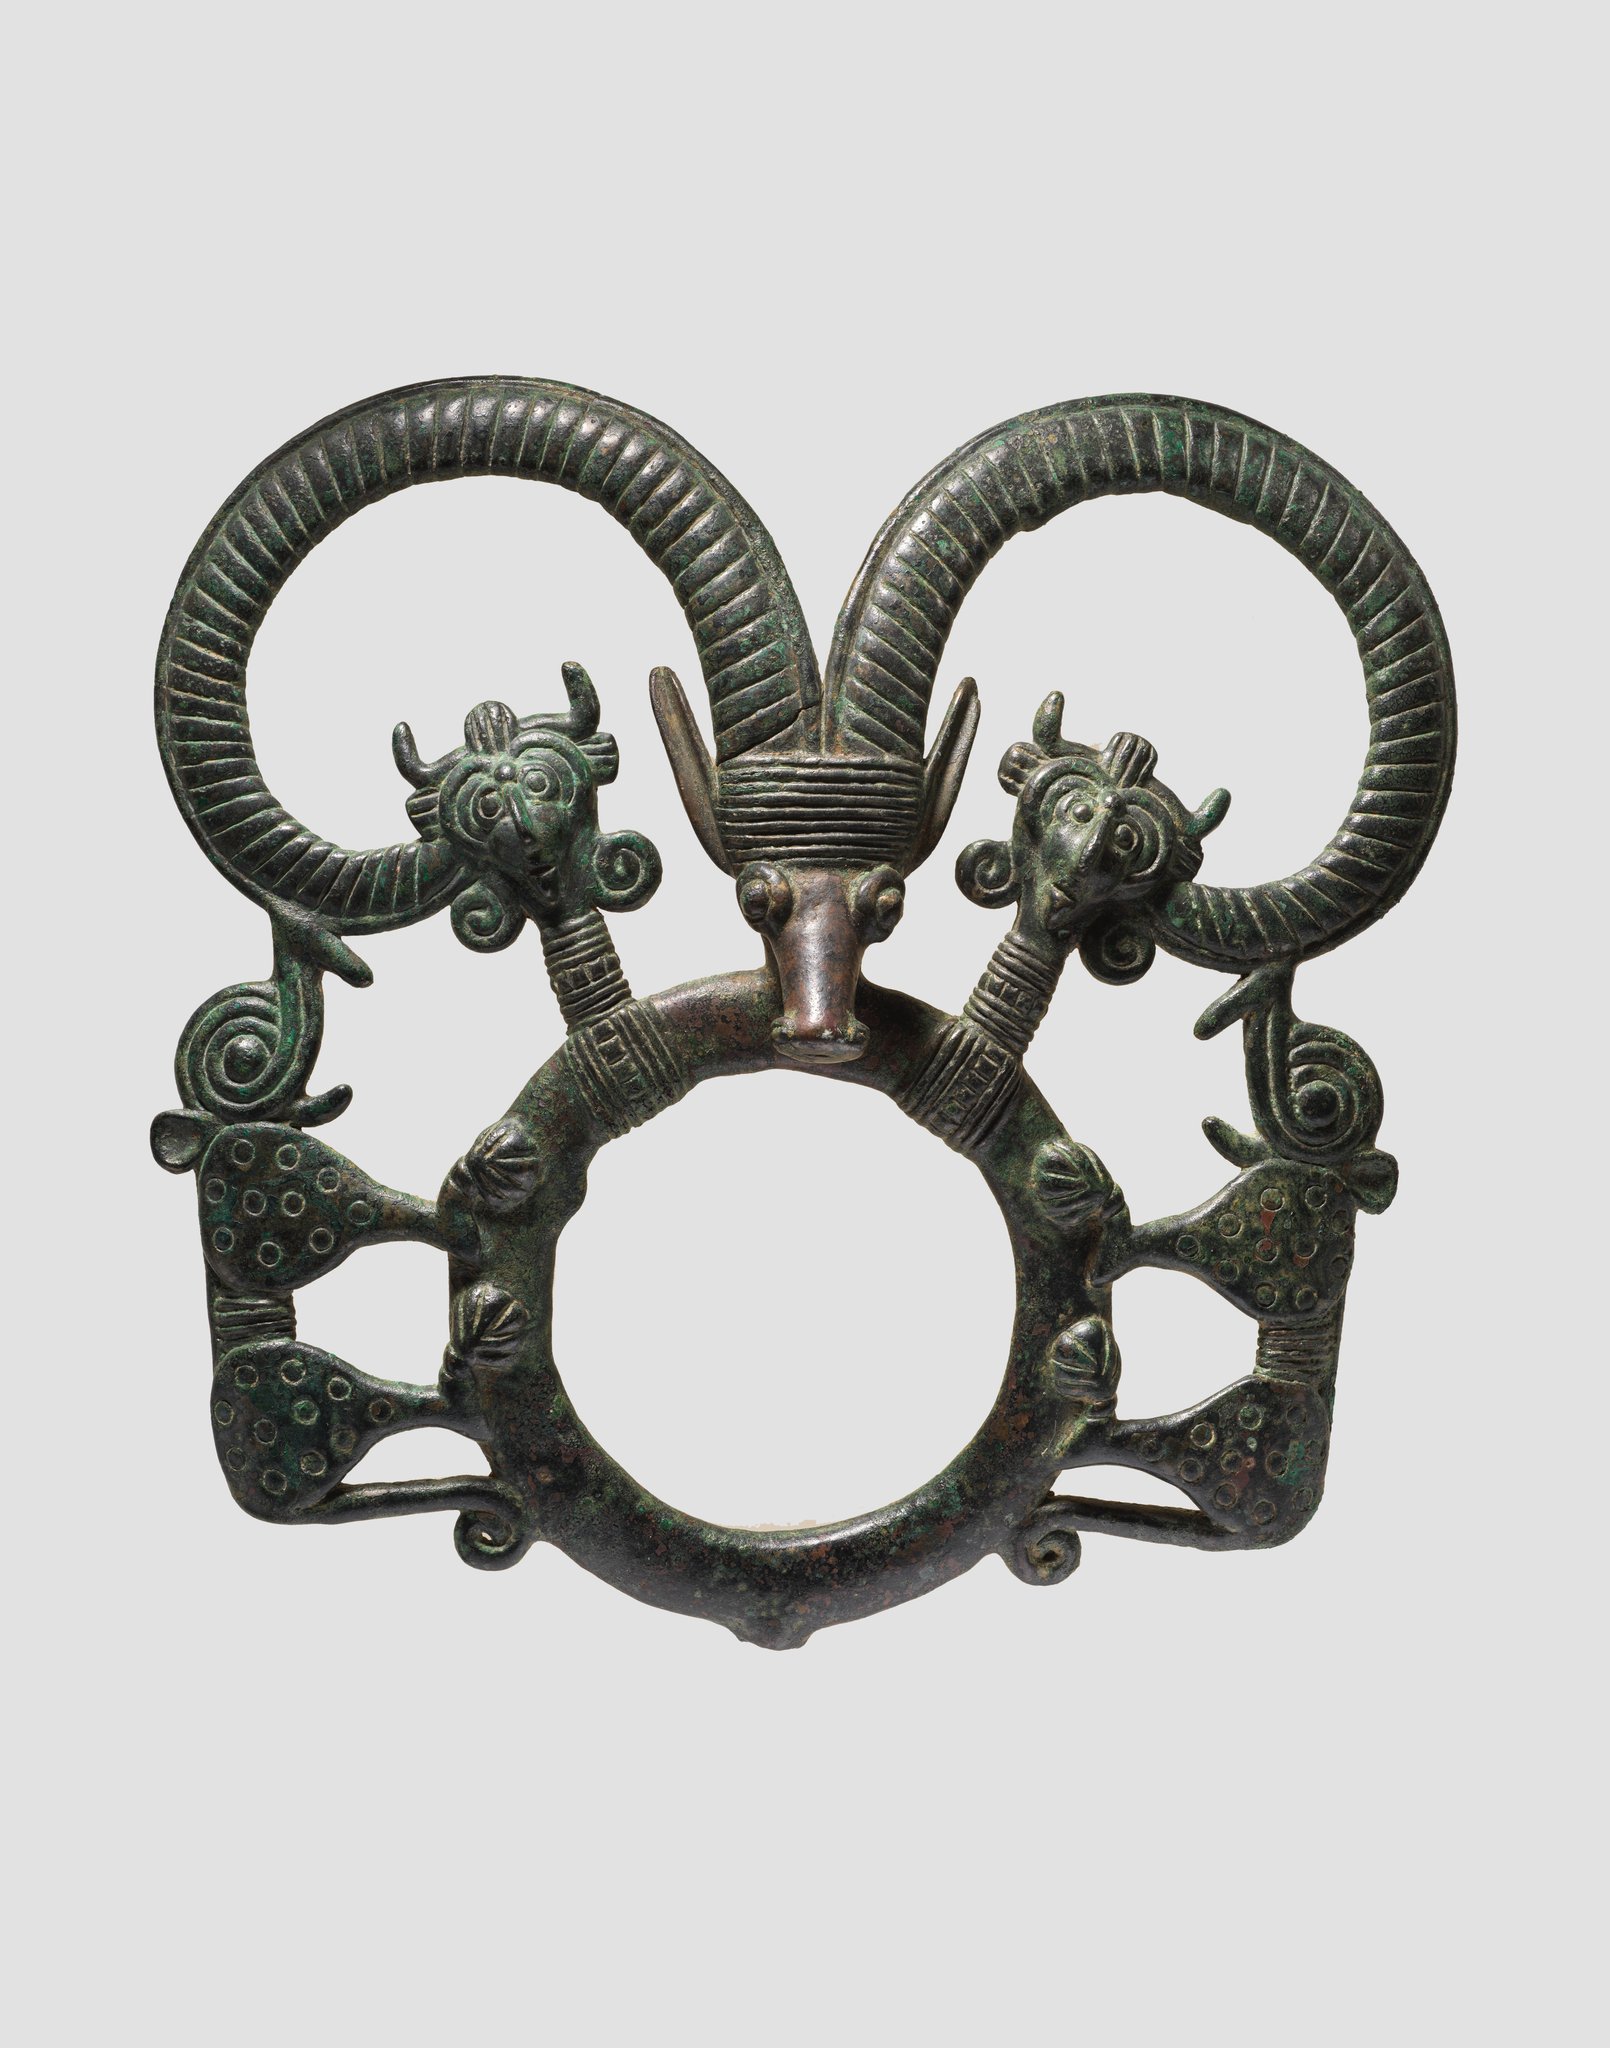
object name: harness ring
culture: iranian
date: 900-801 BCE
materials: bronze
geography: iran, probably from luristan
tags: animals